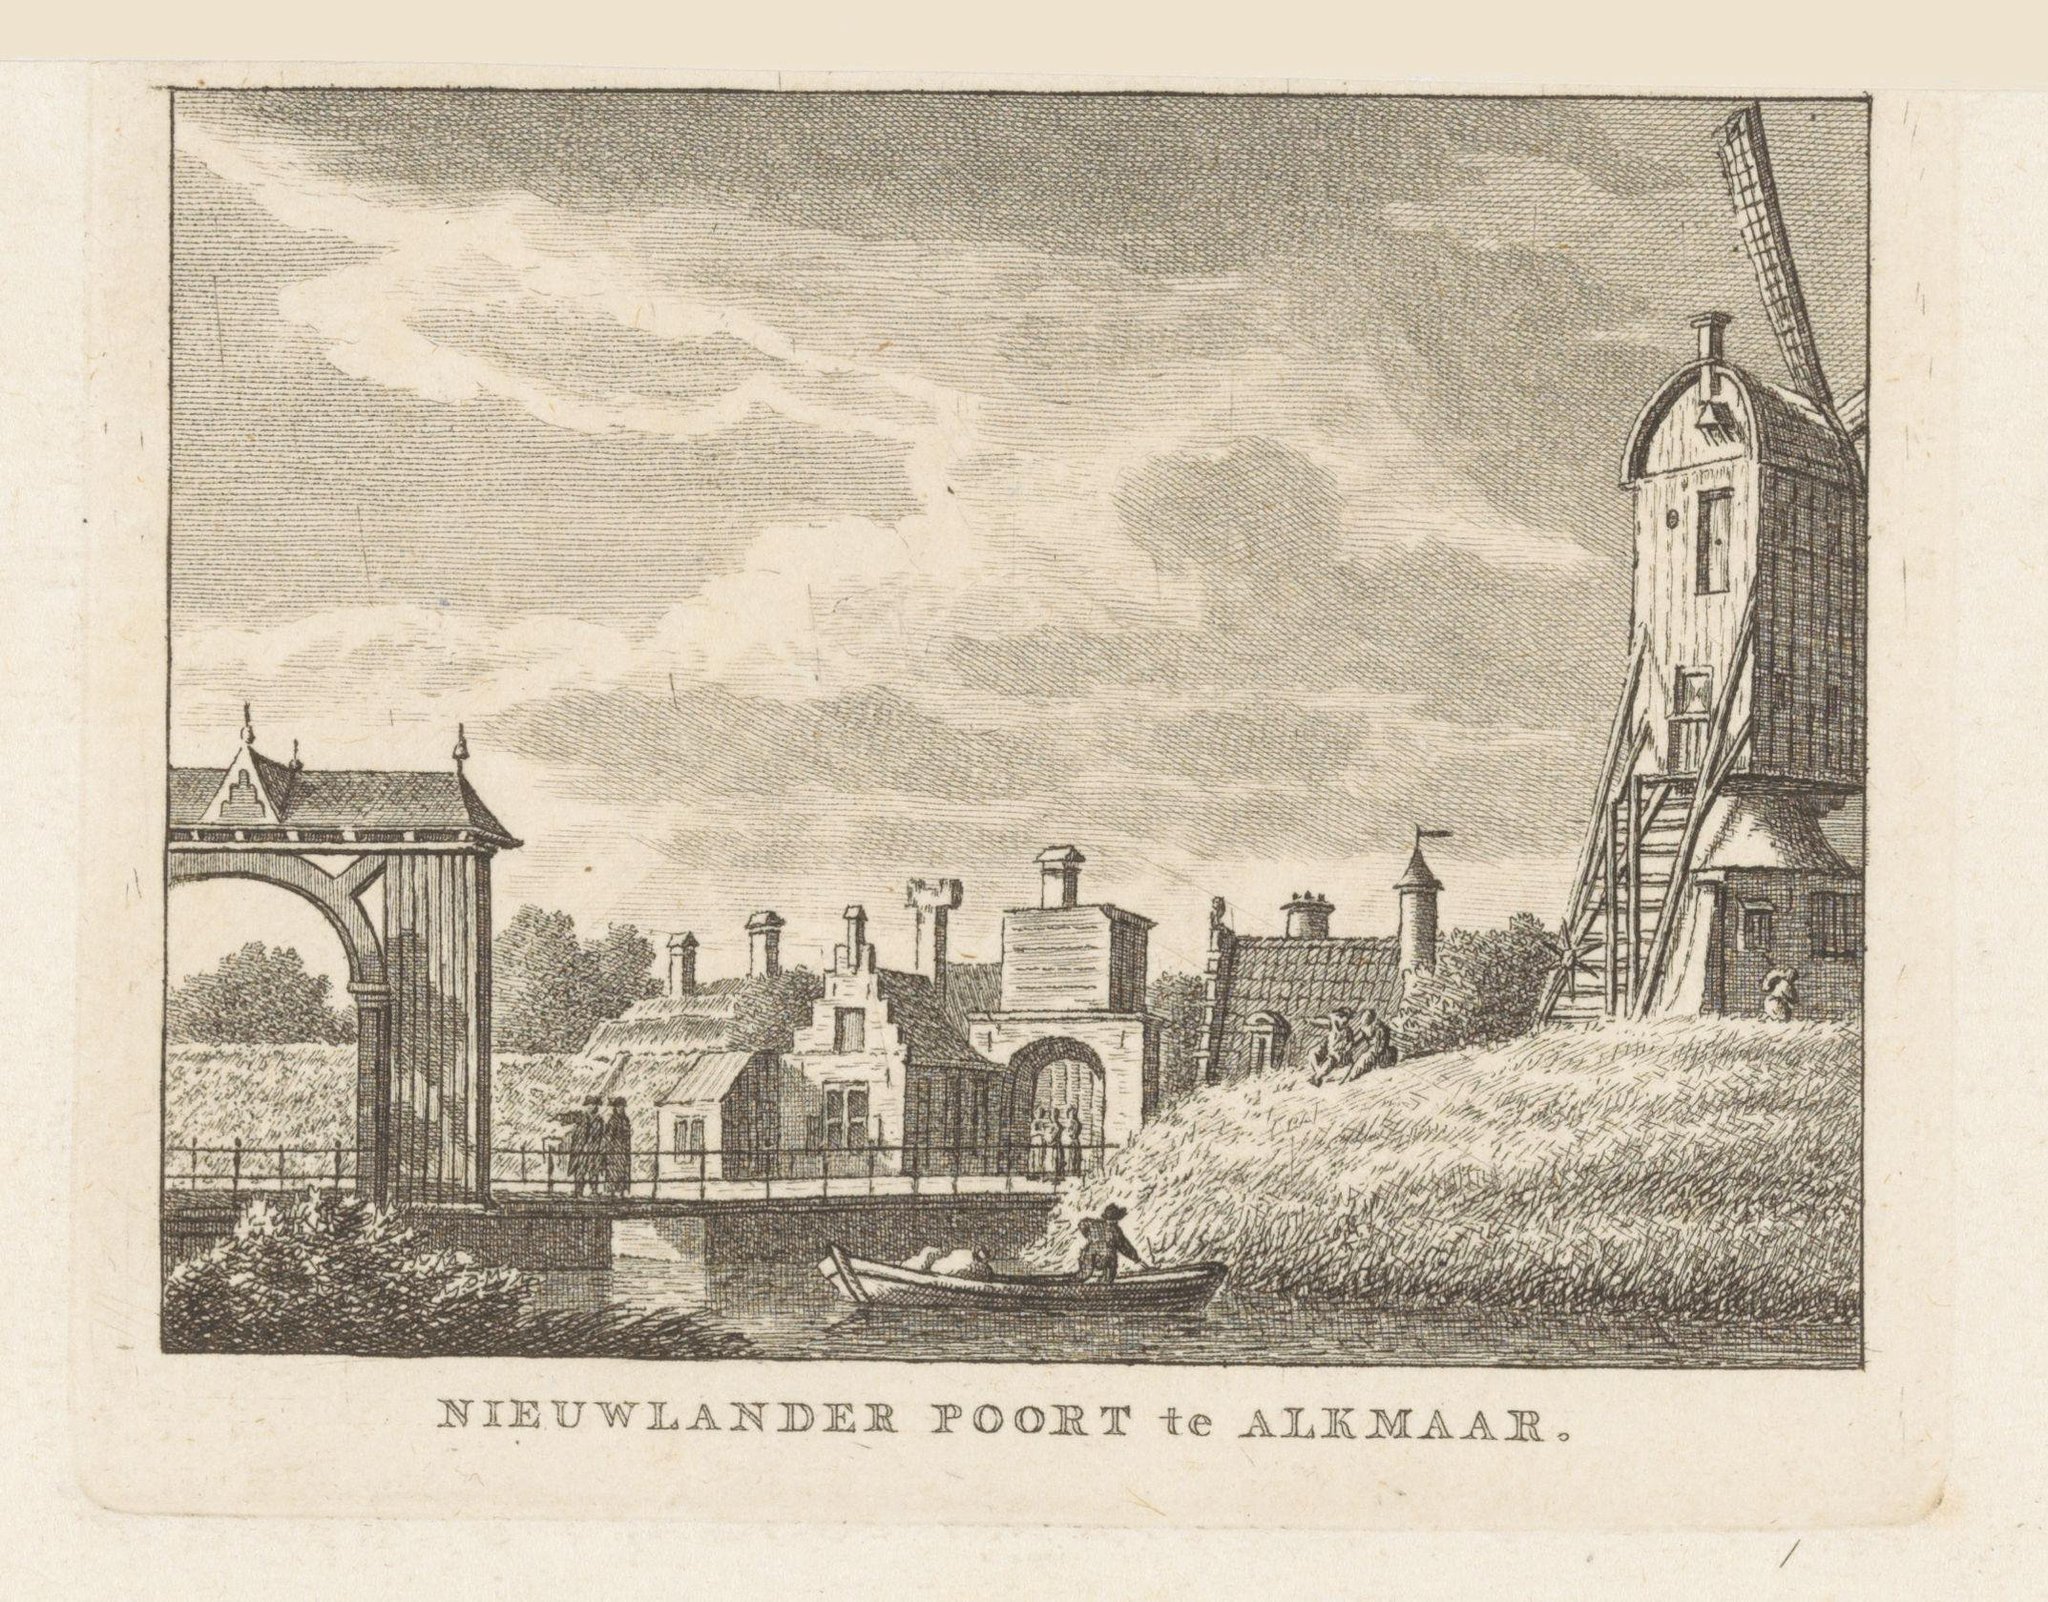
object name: print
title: Gezicht op de Nieuwlanderpoort te Alkmaar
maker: carel frederik bendorp (i)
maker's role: print maker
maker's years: 1736-1814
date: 1786-1792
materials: paper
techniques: engraving, etching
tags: rowing-boat, canoe, etc., bridge, windmill, city-gate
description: Prent uit: Vaderlandsche gezichten, of afbeeldingen van den tegenwoordigen staat der Vereenigde Nederlanden (…). Amsterdam: Hendrik Gartman, Willem Vermandel en Jan Willem Smit, 1786-1792. Uitgegeven in afleveringen met ieder een eigen bifolium en inhoudsopgave. Alle prenten in deze publicatie zijn gegraveerd door Carel Frederik Bendorp (I) en, in de meeste gevallen, gebaseerd op tekeningen van Jan Bulthuis.